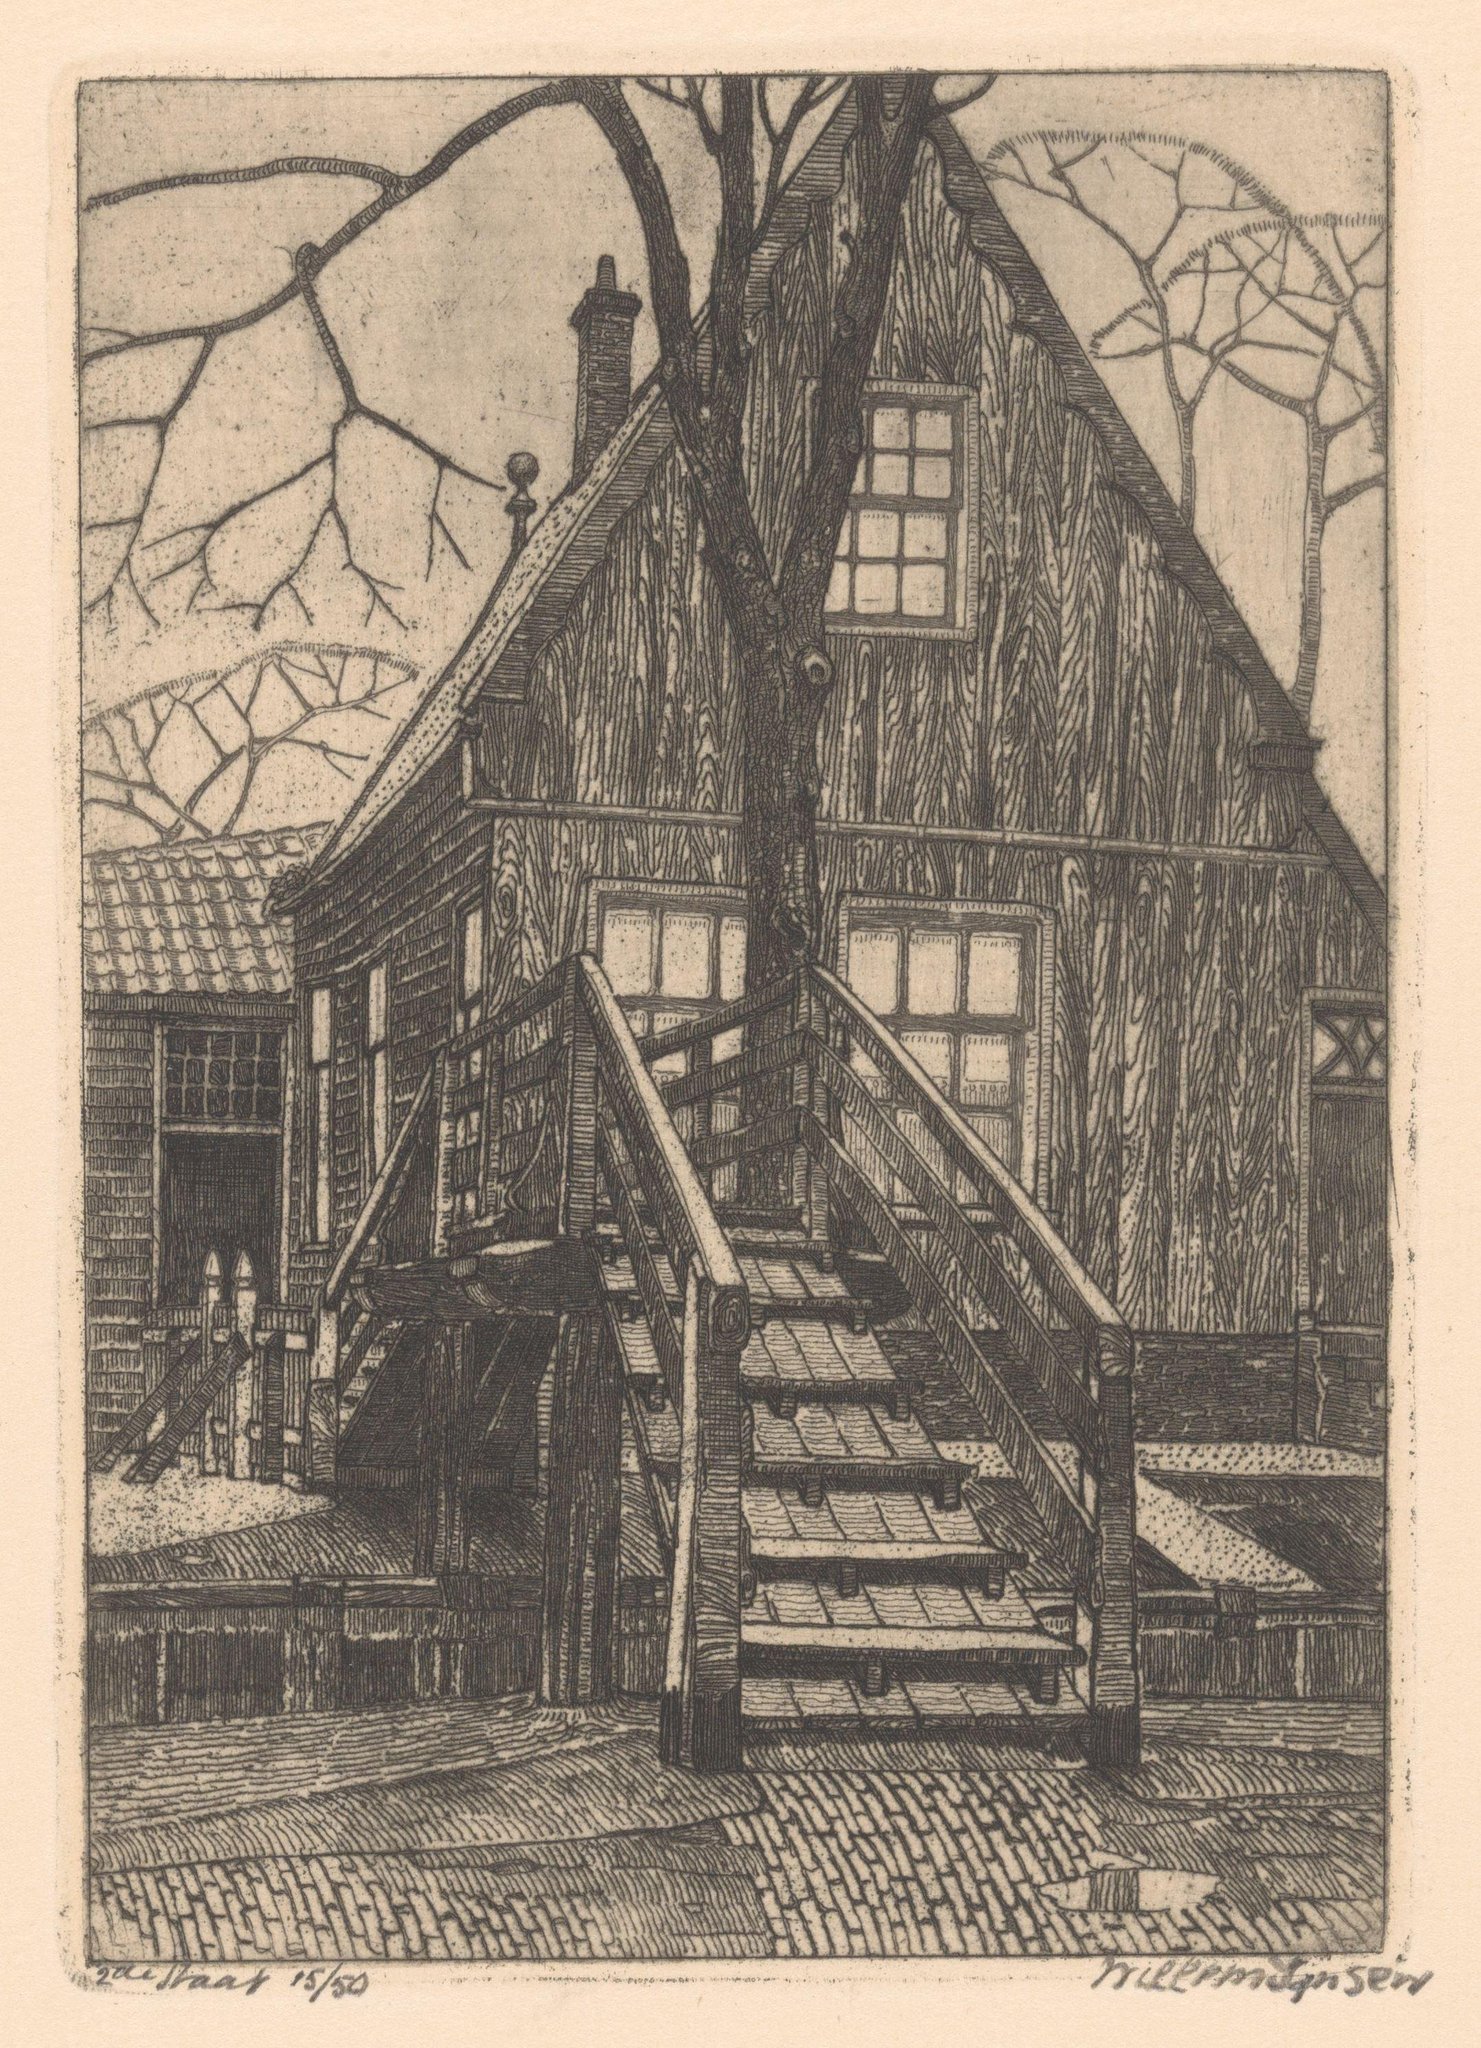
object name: print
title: Huis met brug te Westzaan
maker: willem jansen (graveur)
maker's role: print maker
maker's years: 1892-1969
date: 1922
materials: paper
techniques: etching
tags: housing, bridge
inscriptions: inscription: ‘2de staat 15/50’, collector's mark: Lugt 2228